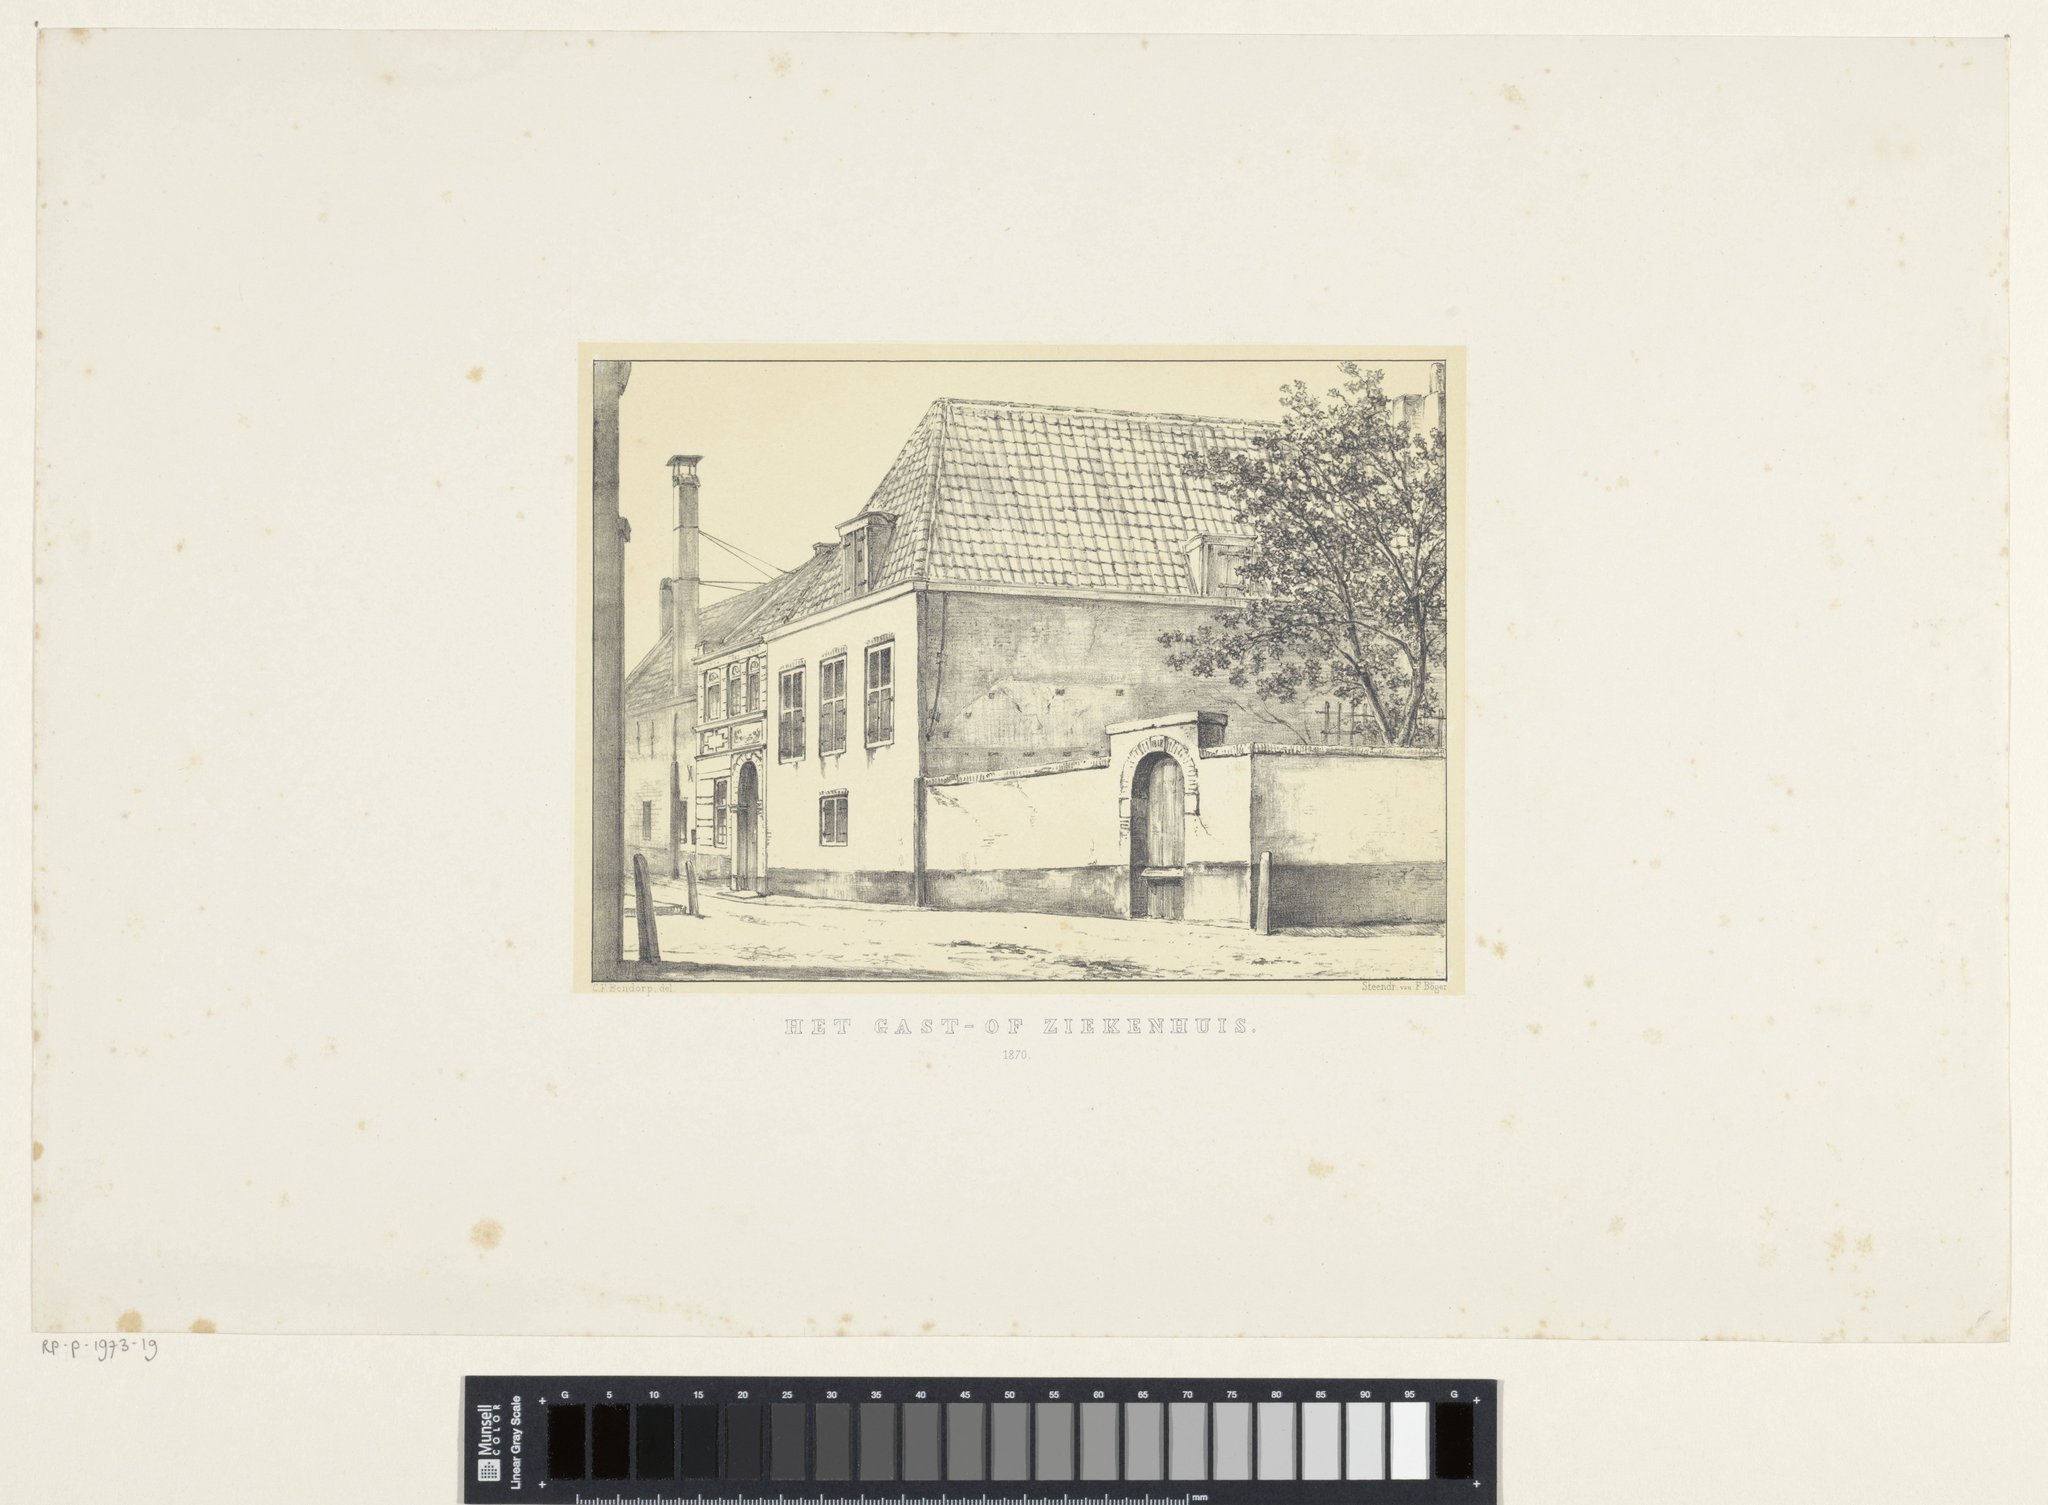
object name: print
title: Het gast- of ziekenhuis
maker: carel frederik bendorp (ii)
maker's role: draughtsman, painter, print maker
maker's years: 1819-1897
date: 1872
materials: paper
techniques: tone lithography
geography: dordrecht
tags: fenced or walled garden; 'hortus conclusus', hospital, street, dordrecht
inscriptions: collector's mark: Lugt 2760, collector's mark: Lugt 2228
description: Aan een straat staan drie gebouwen. Rechts daarvan een ommuurde tuin met daarin een boom. Onder de afbeelding het jaartal: 1870.